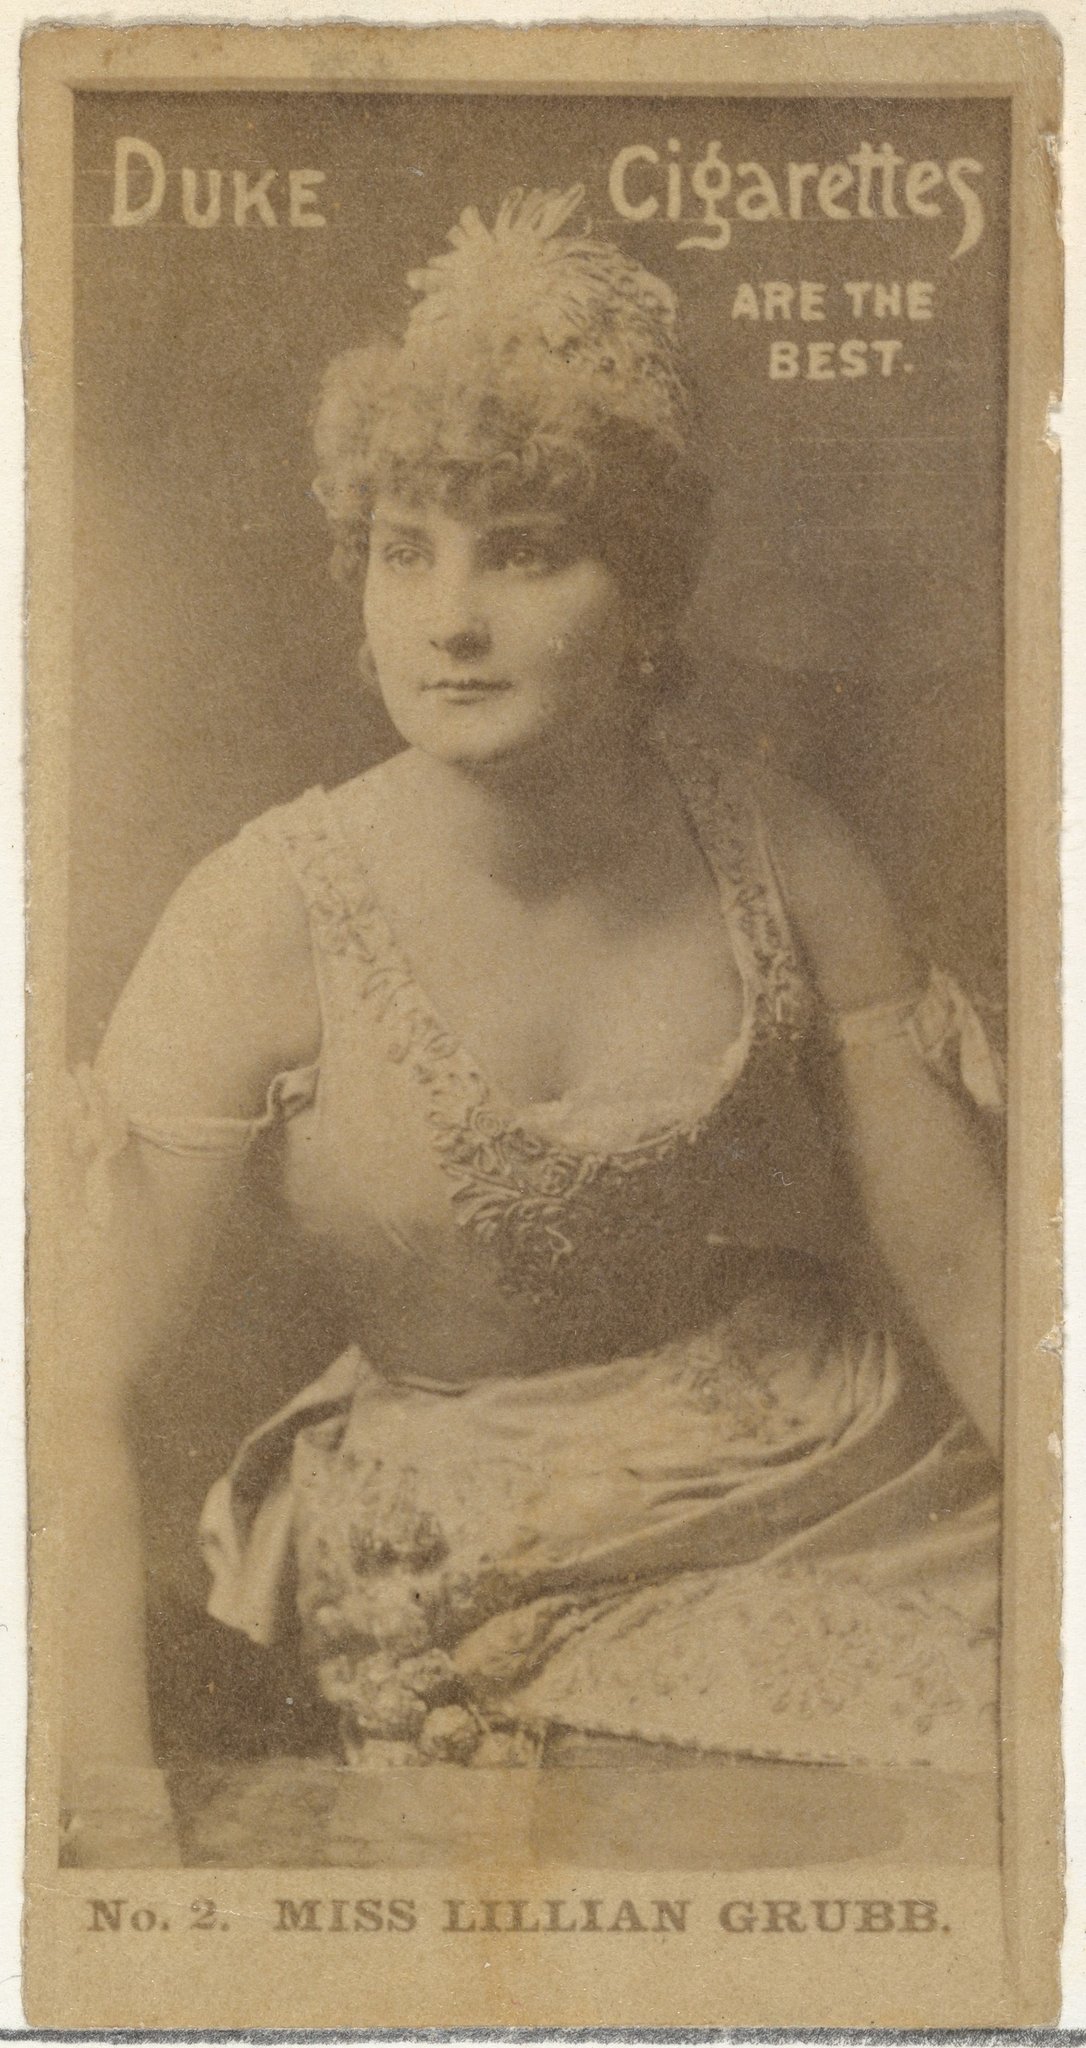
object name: photograph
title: Card Number 2, Miss Lillian Grubb, from the Actors and Actresses series (N145-6) issued by Duke Sons & Co. to promote Duke Cigarettes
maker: w. duke, sons & co.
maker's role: publisher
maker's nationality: american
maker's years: 1870-1920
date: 1880-1889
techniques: albumen silver print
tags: portraits,women,actresses